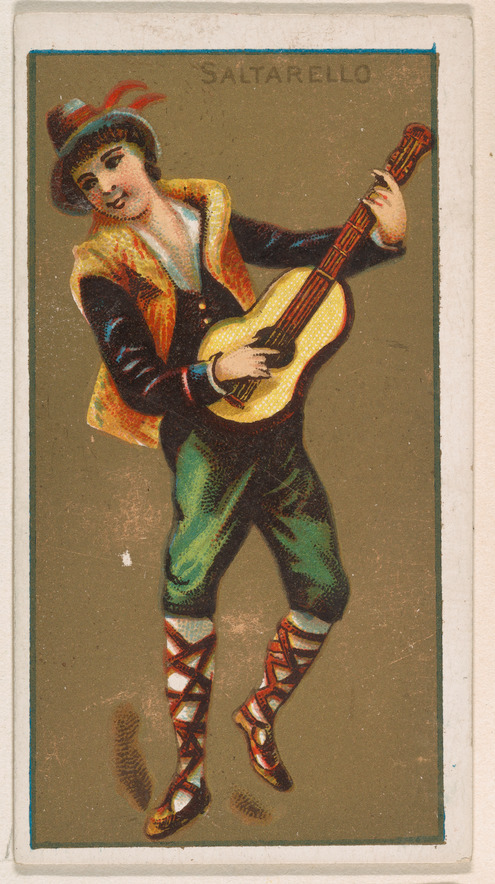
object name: print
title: Saltarello, from National Dances (N225, Type 1) issued by Kinney Bros.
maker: kinney brothers tobacco company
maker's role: publisher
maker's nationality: american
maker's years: 1869-2011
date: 1889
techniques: color lithograph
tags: dance,men,dancing,guitars